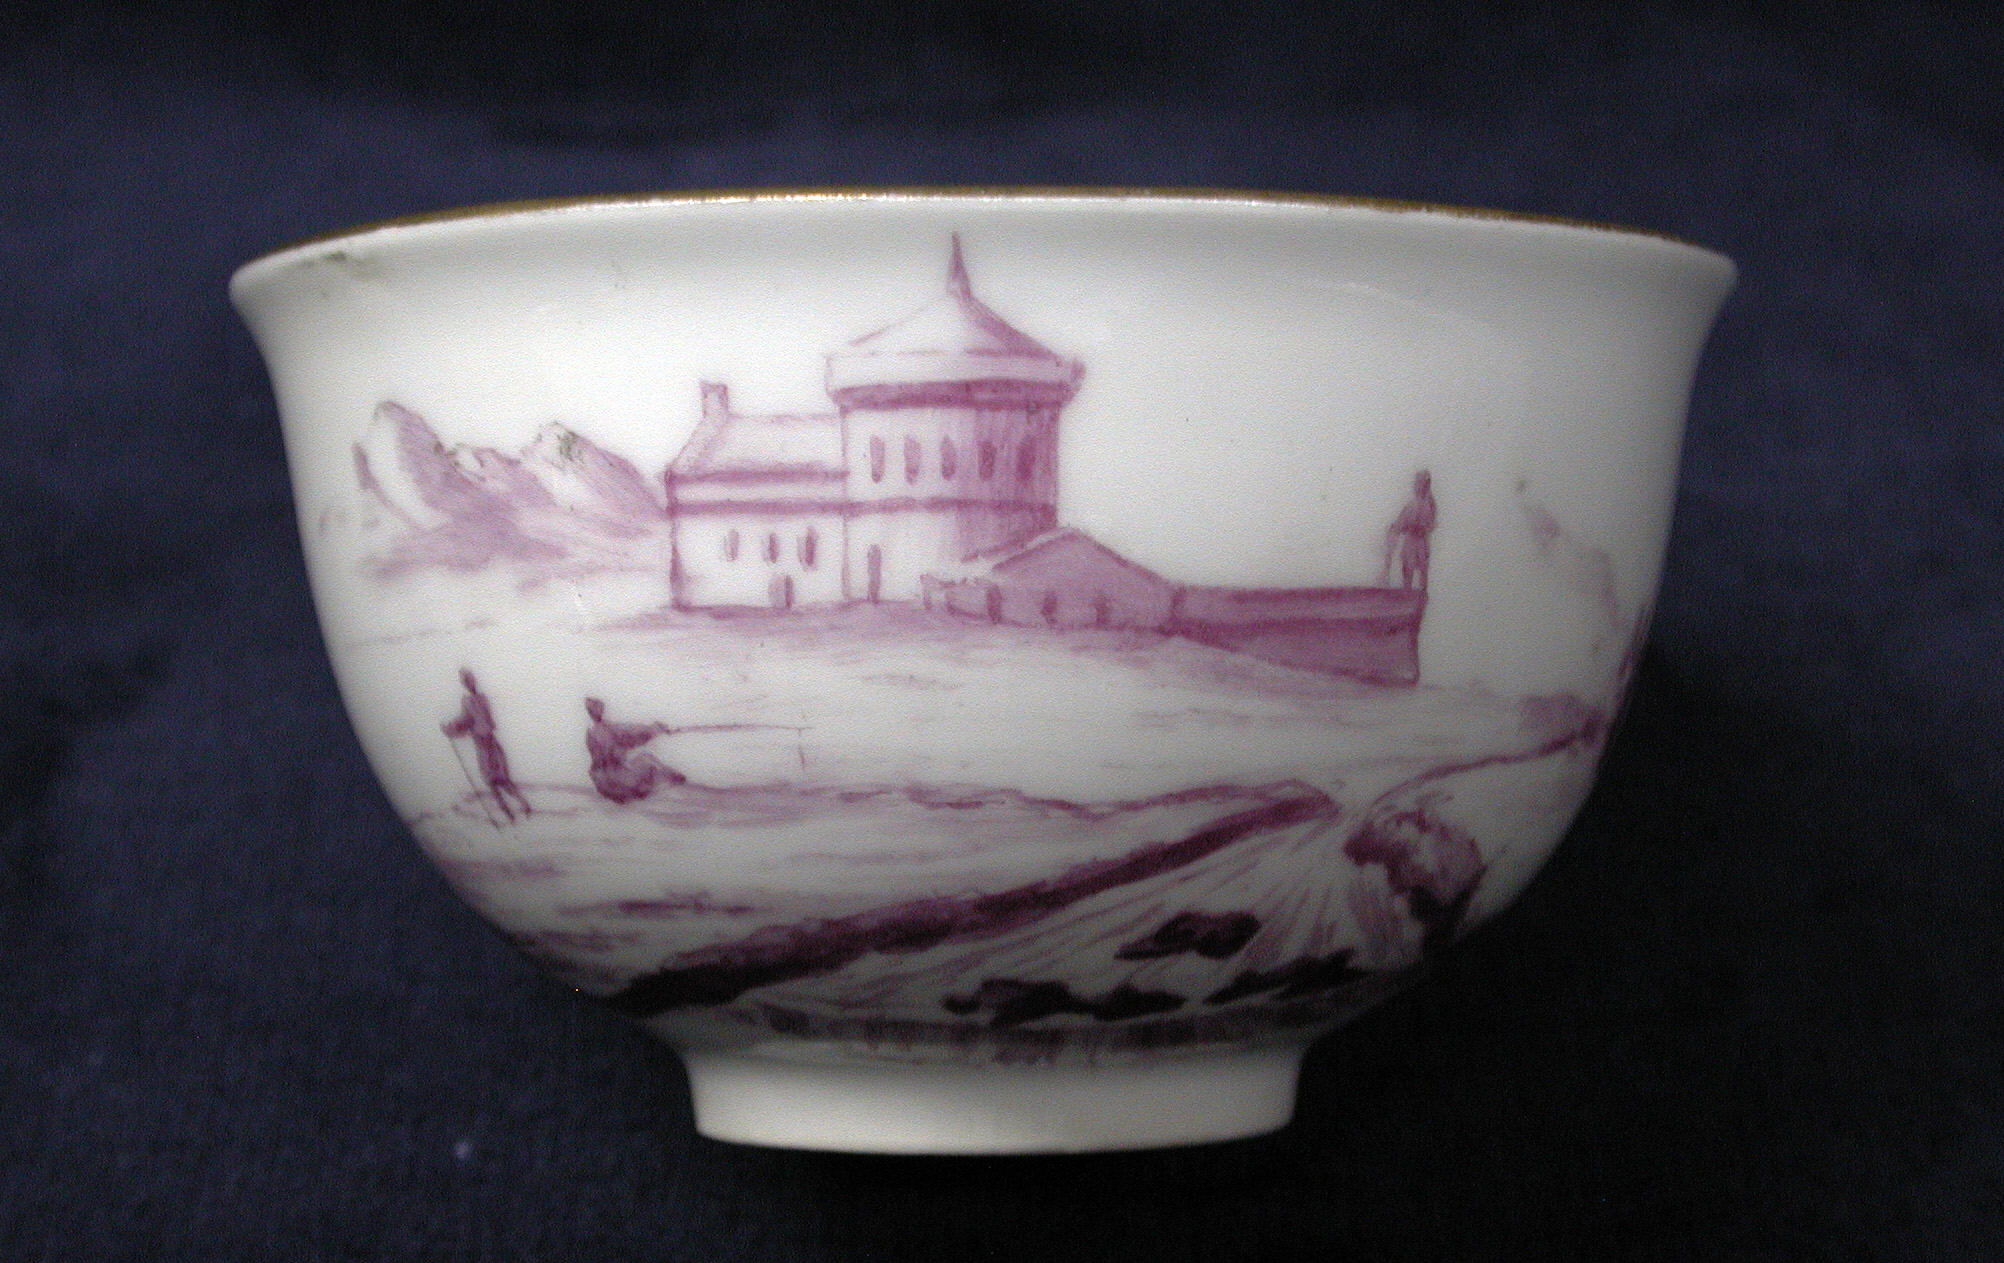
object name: teabowl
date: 1701-1800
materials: hard paste porcelain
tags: buildings